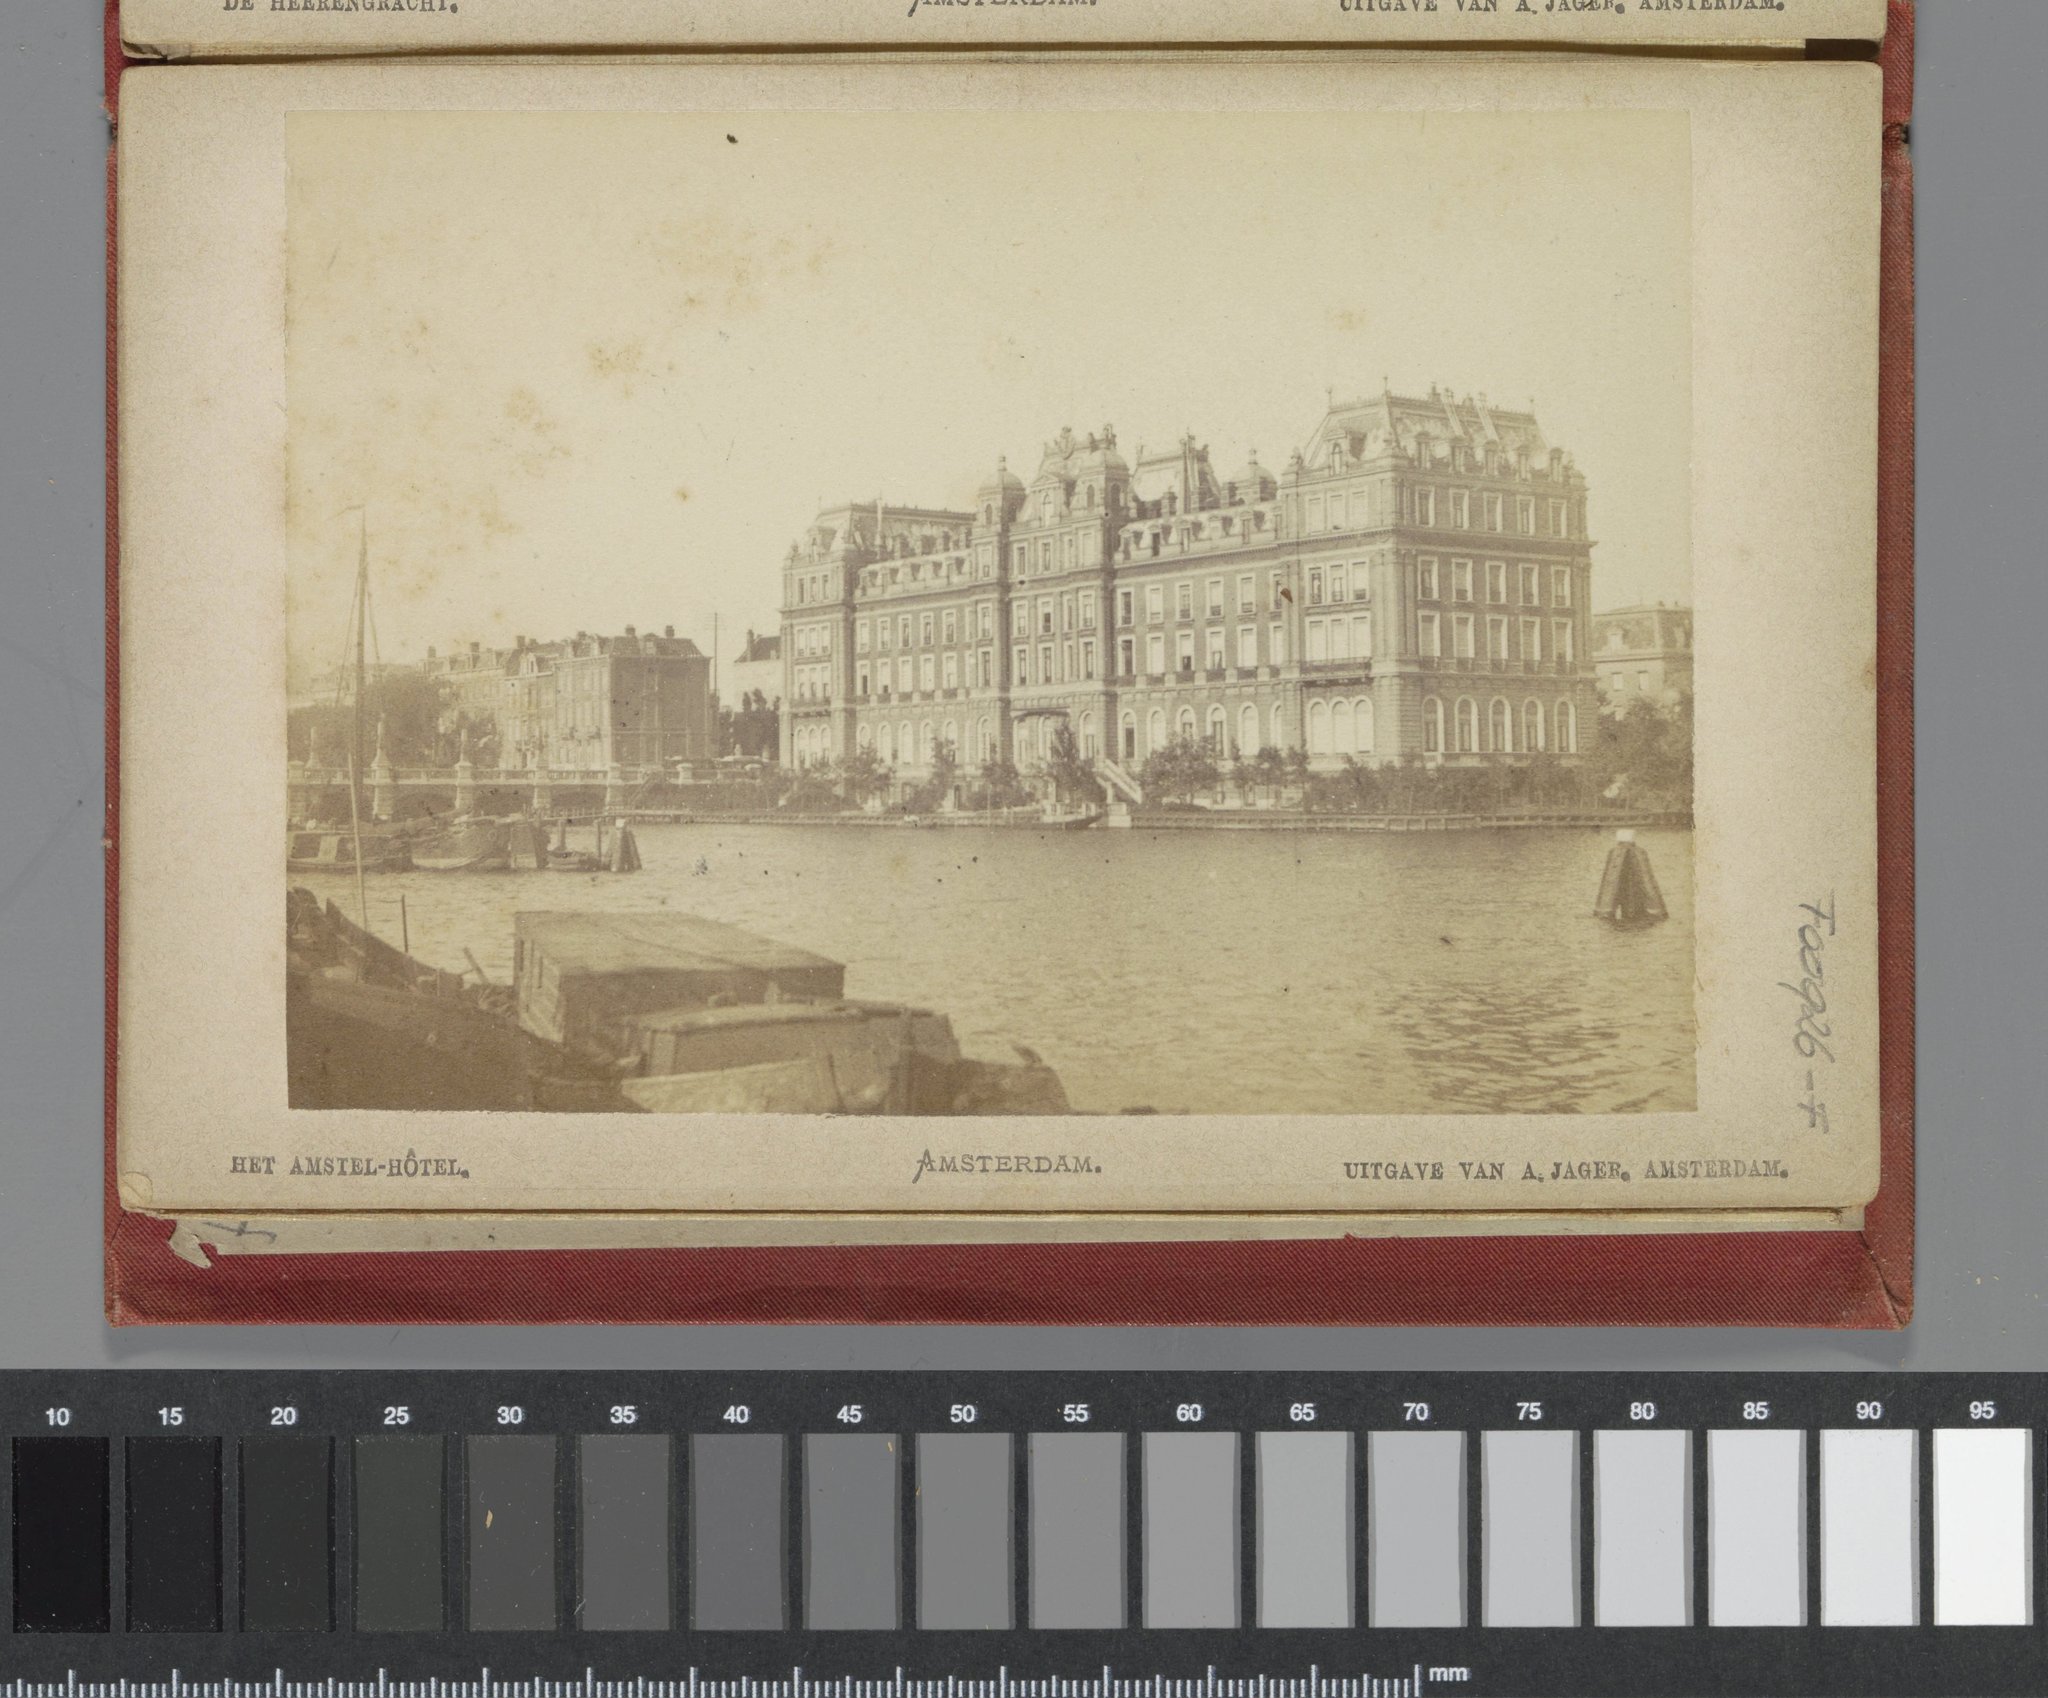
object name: photograph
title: Gezicht op het Amstel Hotel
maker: andries jager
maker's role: publisher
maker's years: 1825-1905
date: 1860-1900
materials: cardboard, photographic support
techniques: albumen print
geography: amsterdam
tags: river, hotel, hostelry, inn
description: Onderdeel van Leporelloalbum met 12 foto's van Amsterdam.